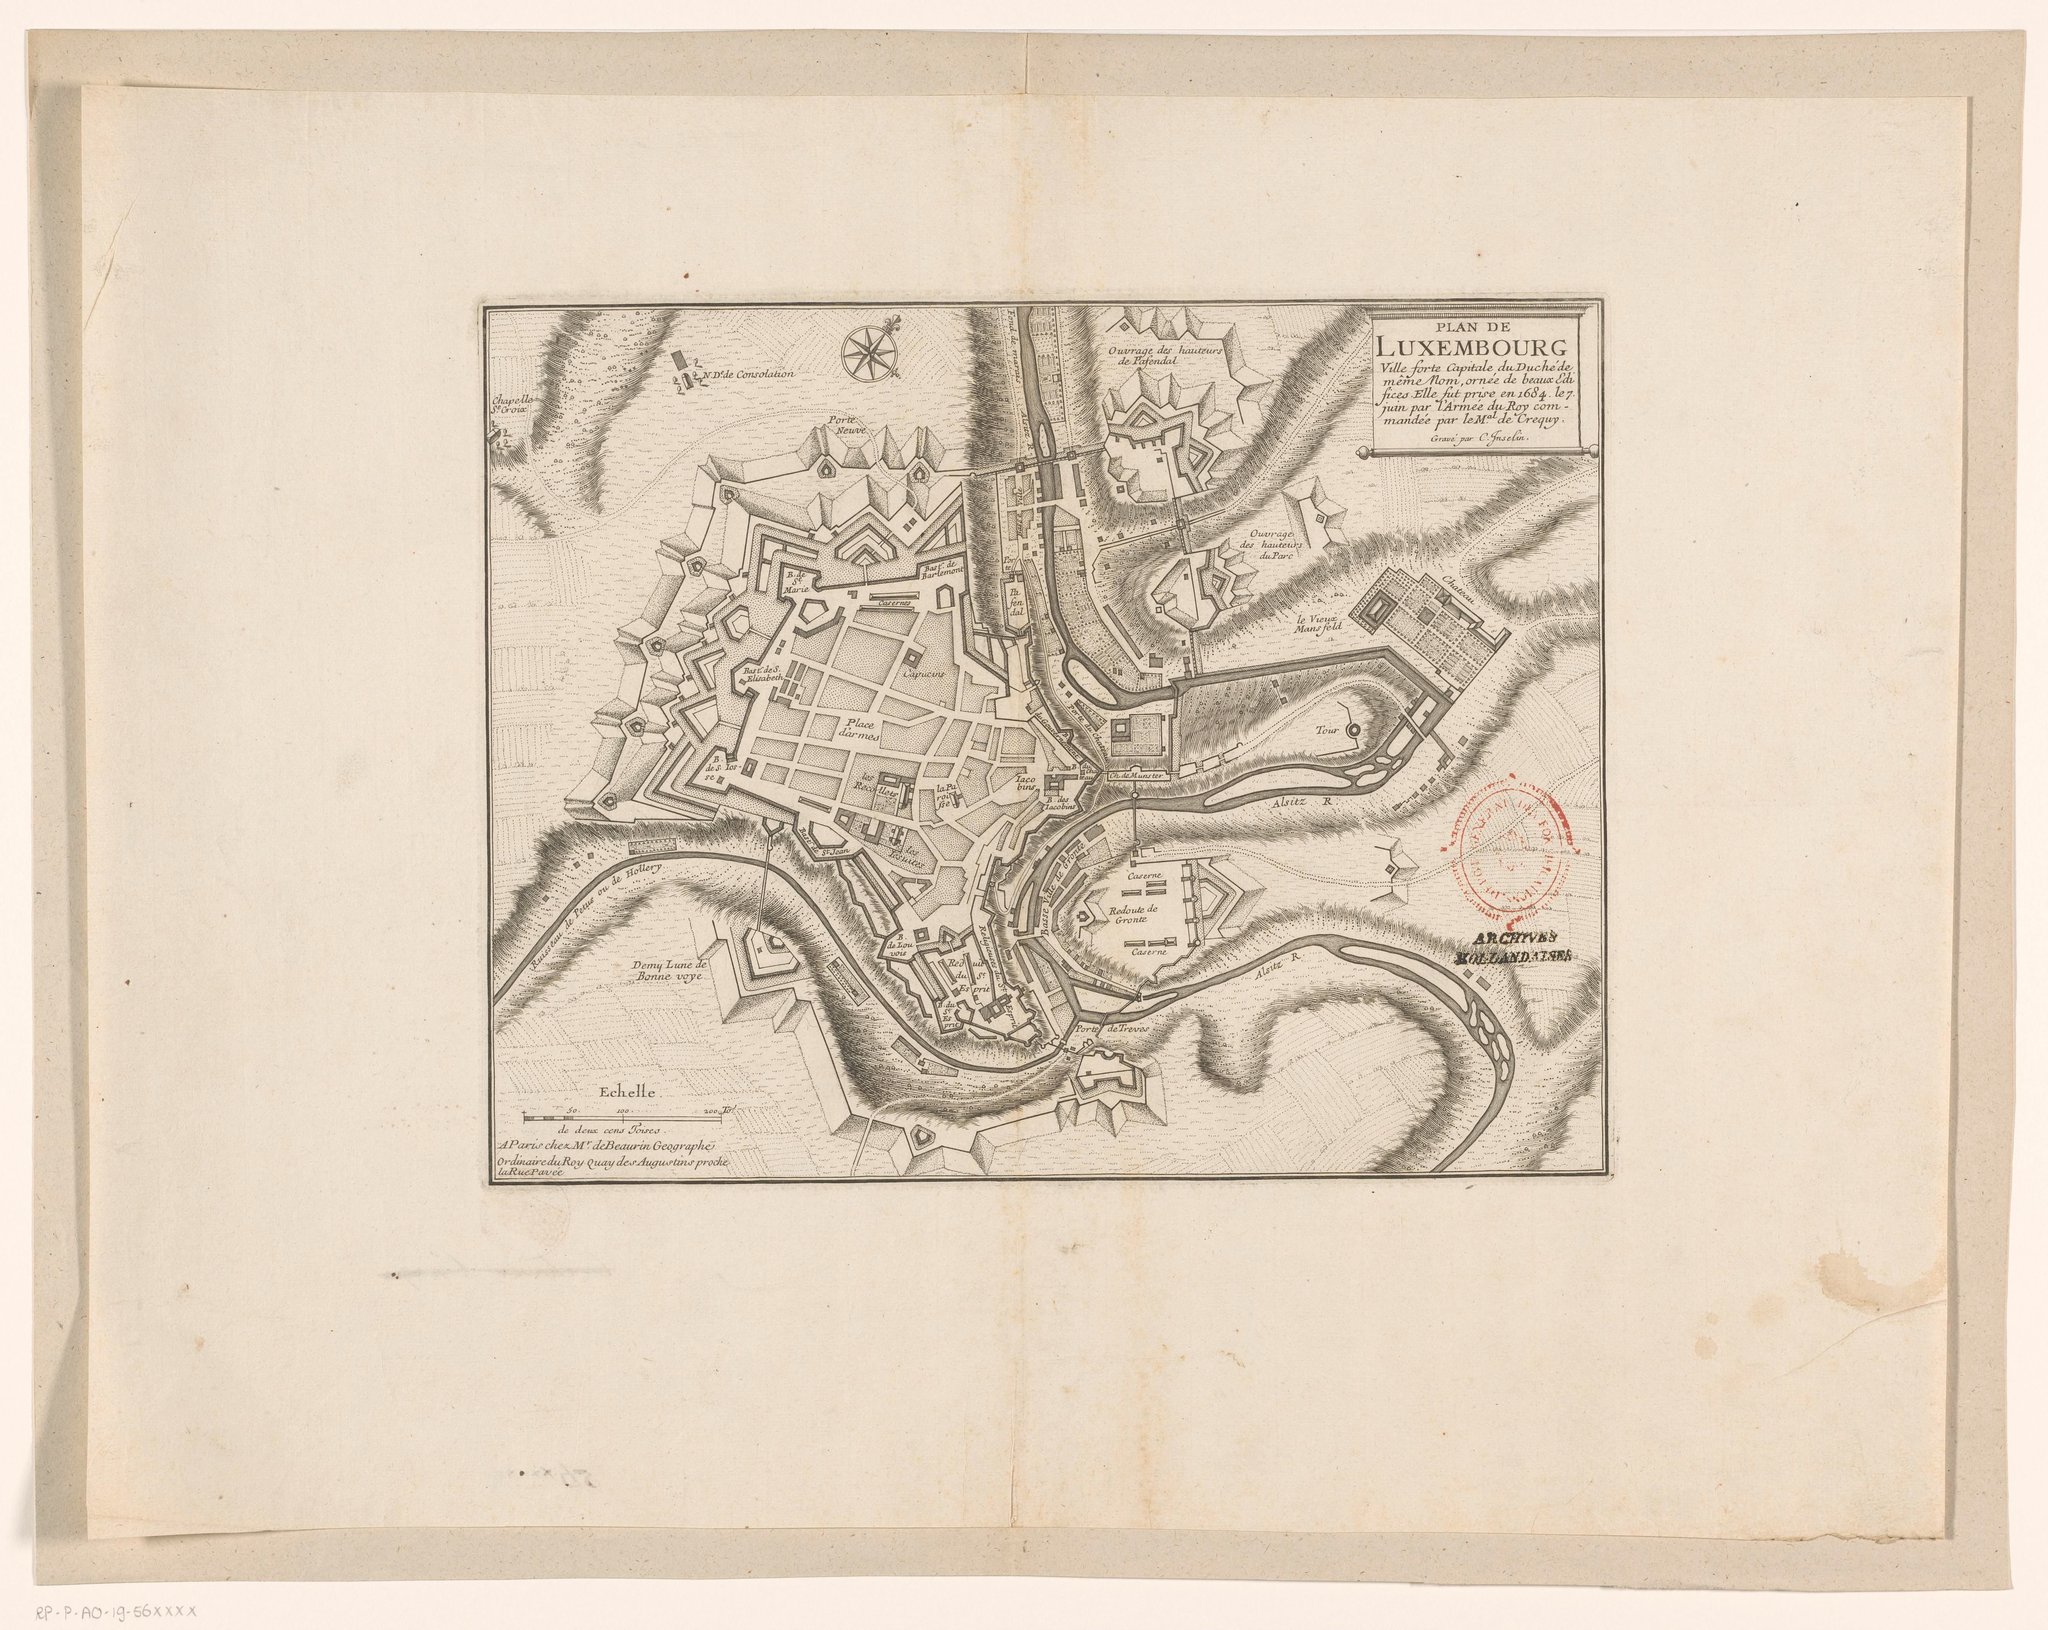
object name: print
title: Plan de Luxembourg ville forte capitale du duché de même nom (...)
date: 1721-1725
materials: paper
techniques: engraving, etching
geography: paris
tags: fortified city, maps of cities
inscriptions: collector's mark: ‘DEPOT GENERAL DES FORTIFICATIONS’, collector's mark: ‘ARCHIVES HOLLANDAISES’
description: Vestingplattegrond van Luxemburg. Rechtsboven de titelcartouche. Linksonder een schaalstok: Echelle de deux cens Toises.